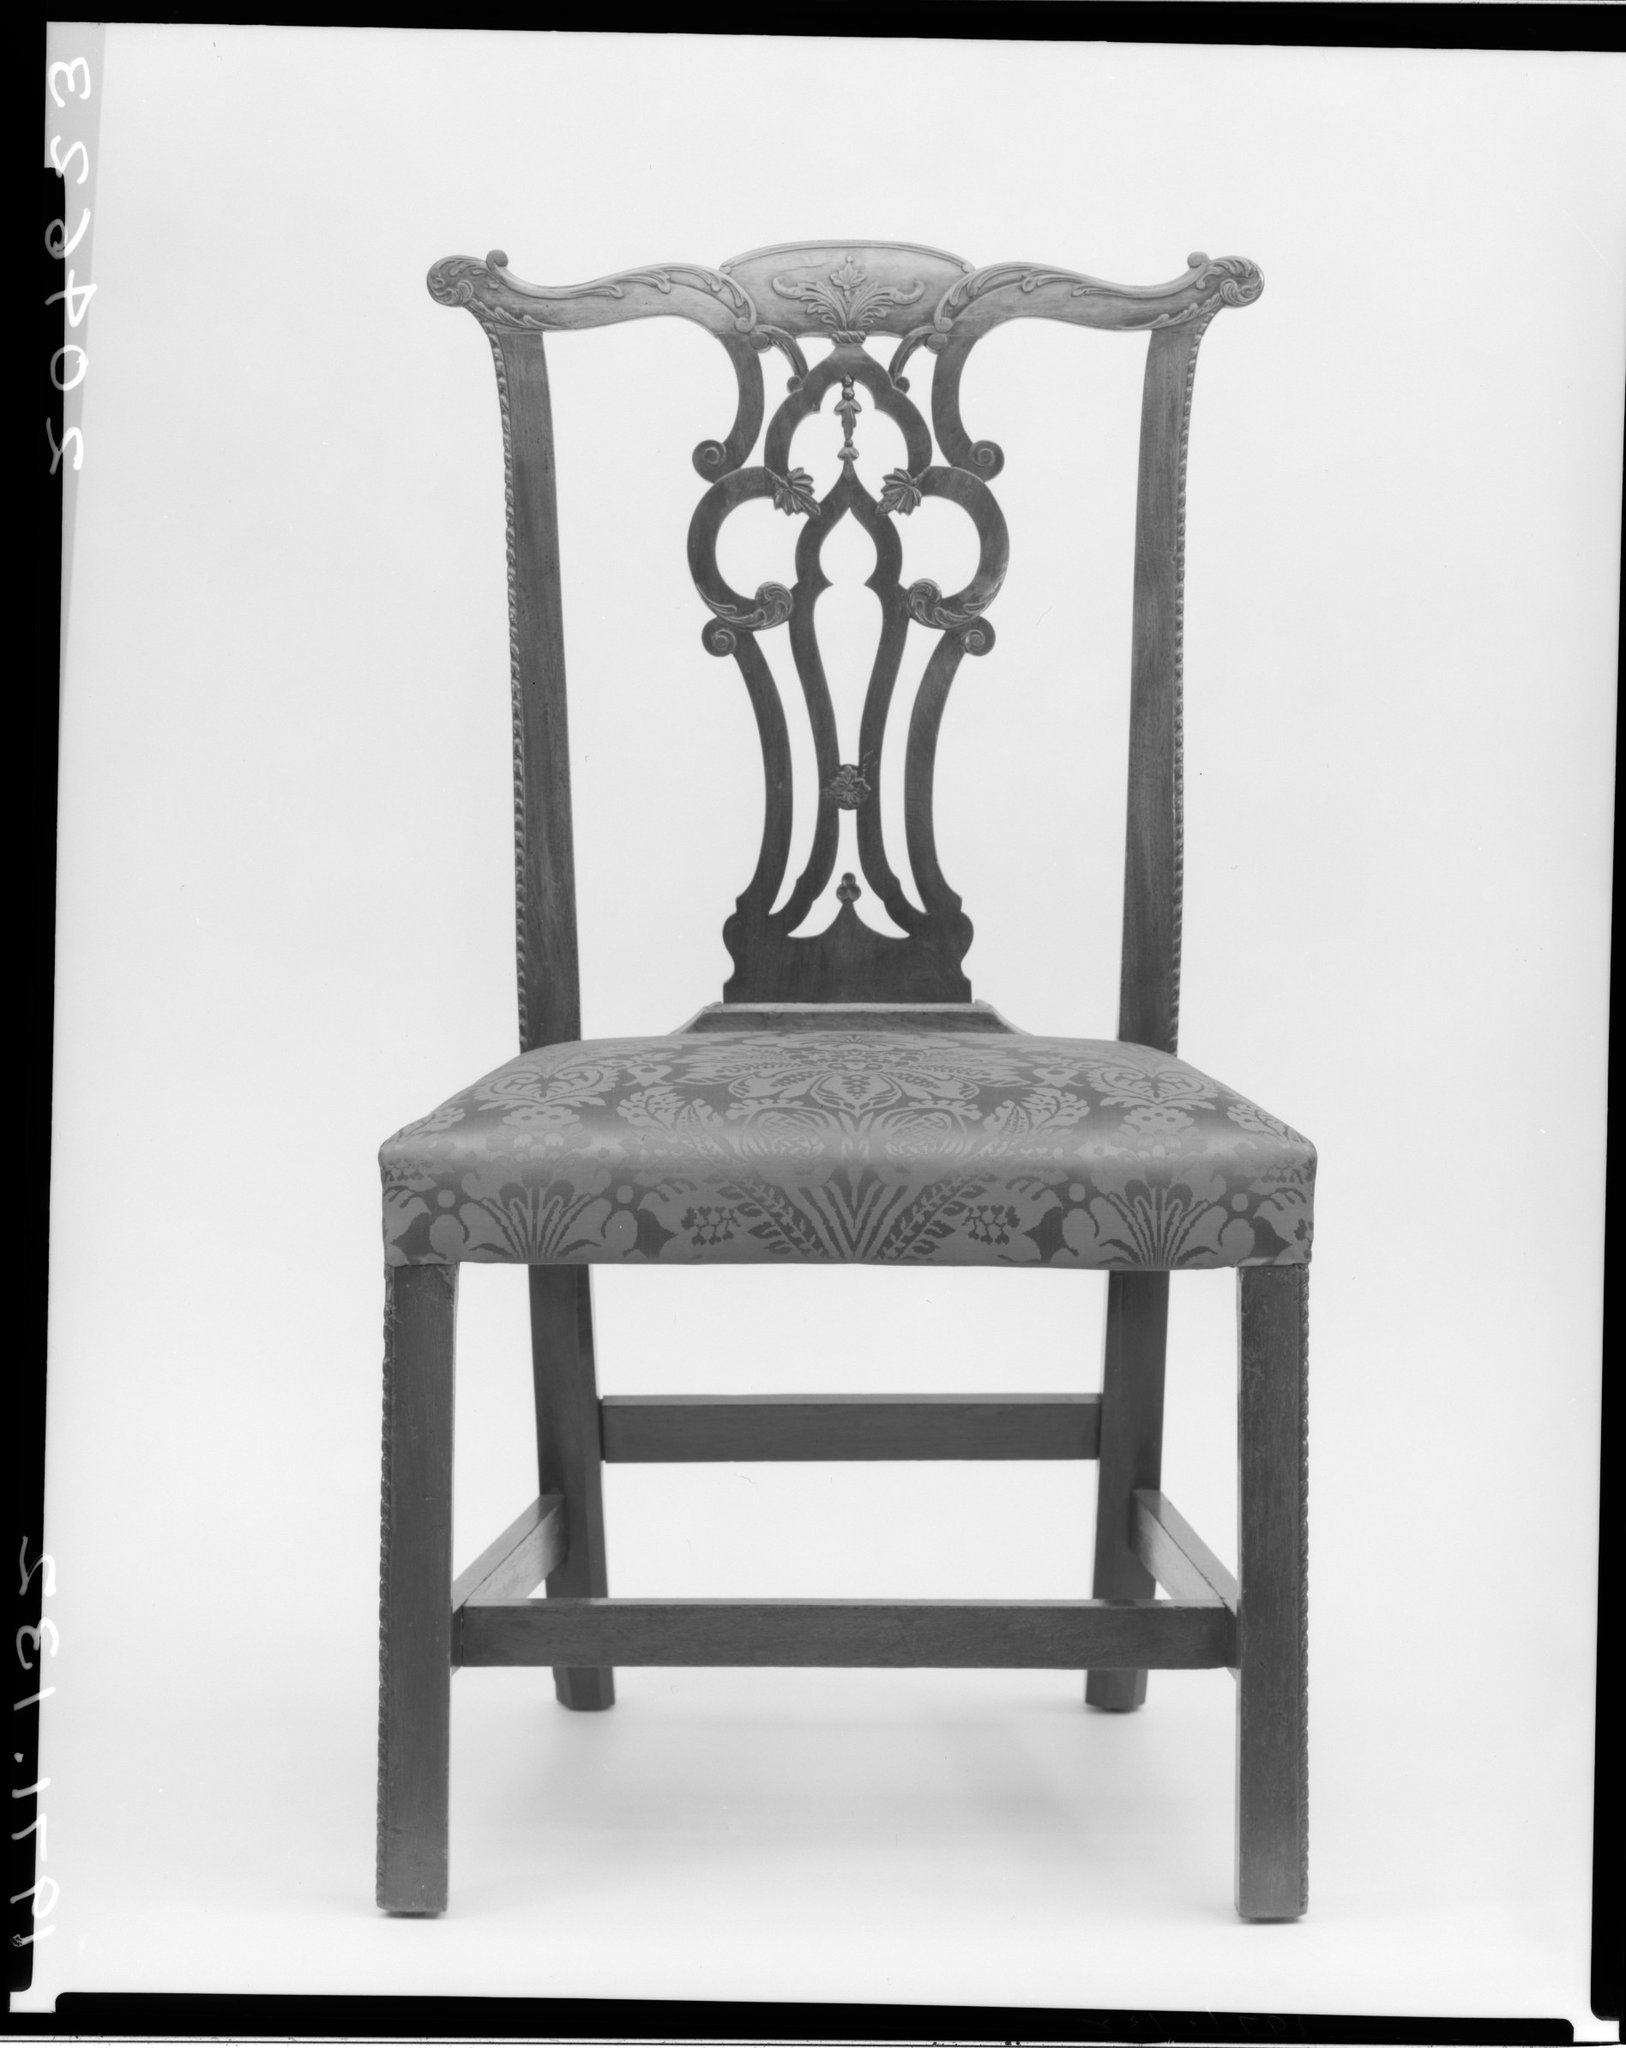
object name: side chair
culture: american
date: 1760-1790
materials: wood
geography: united states